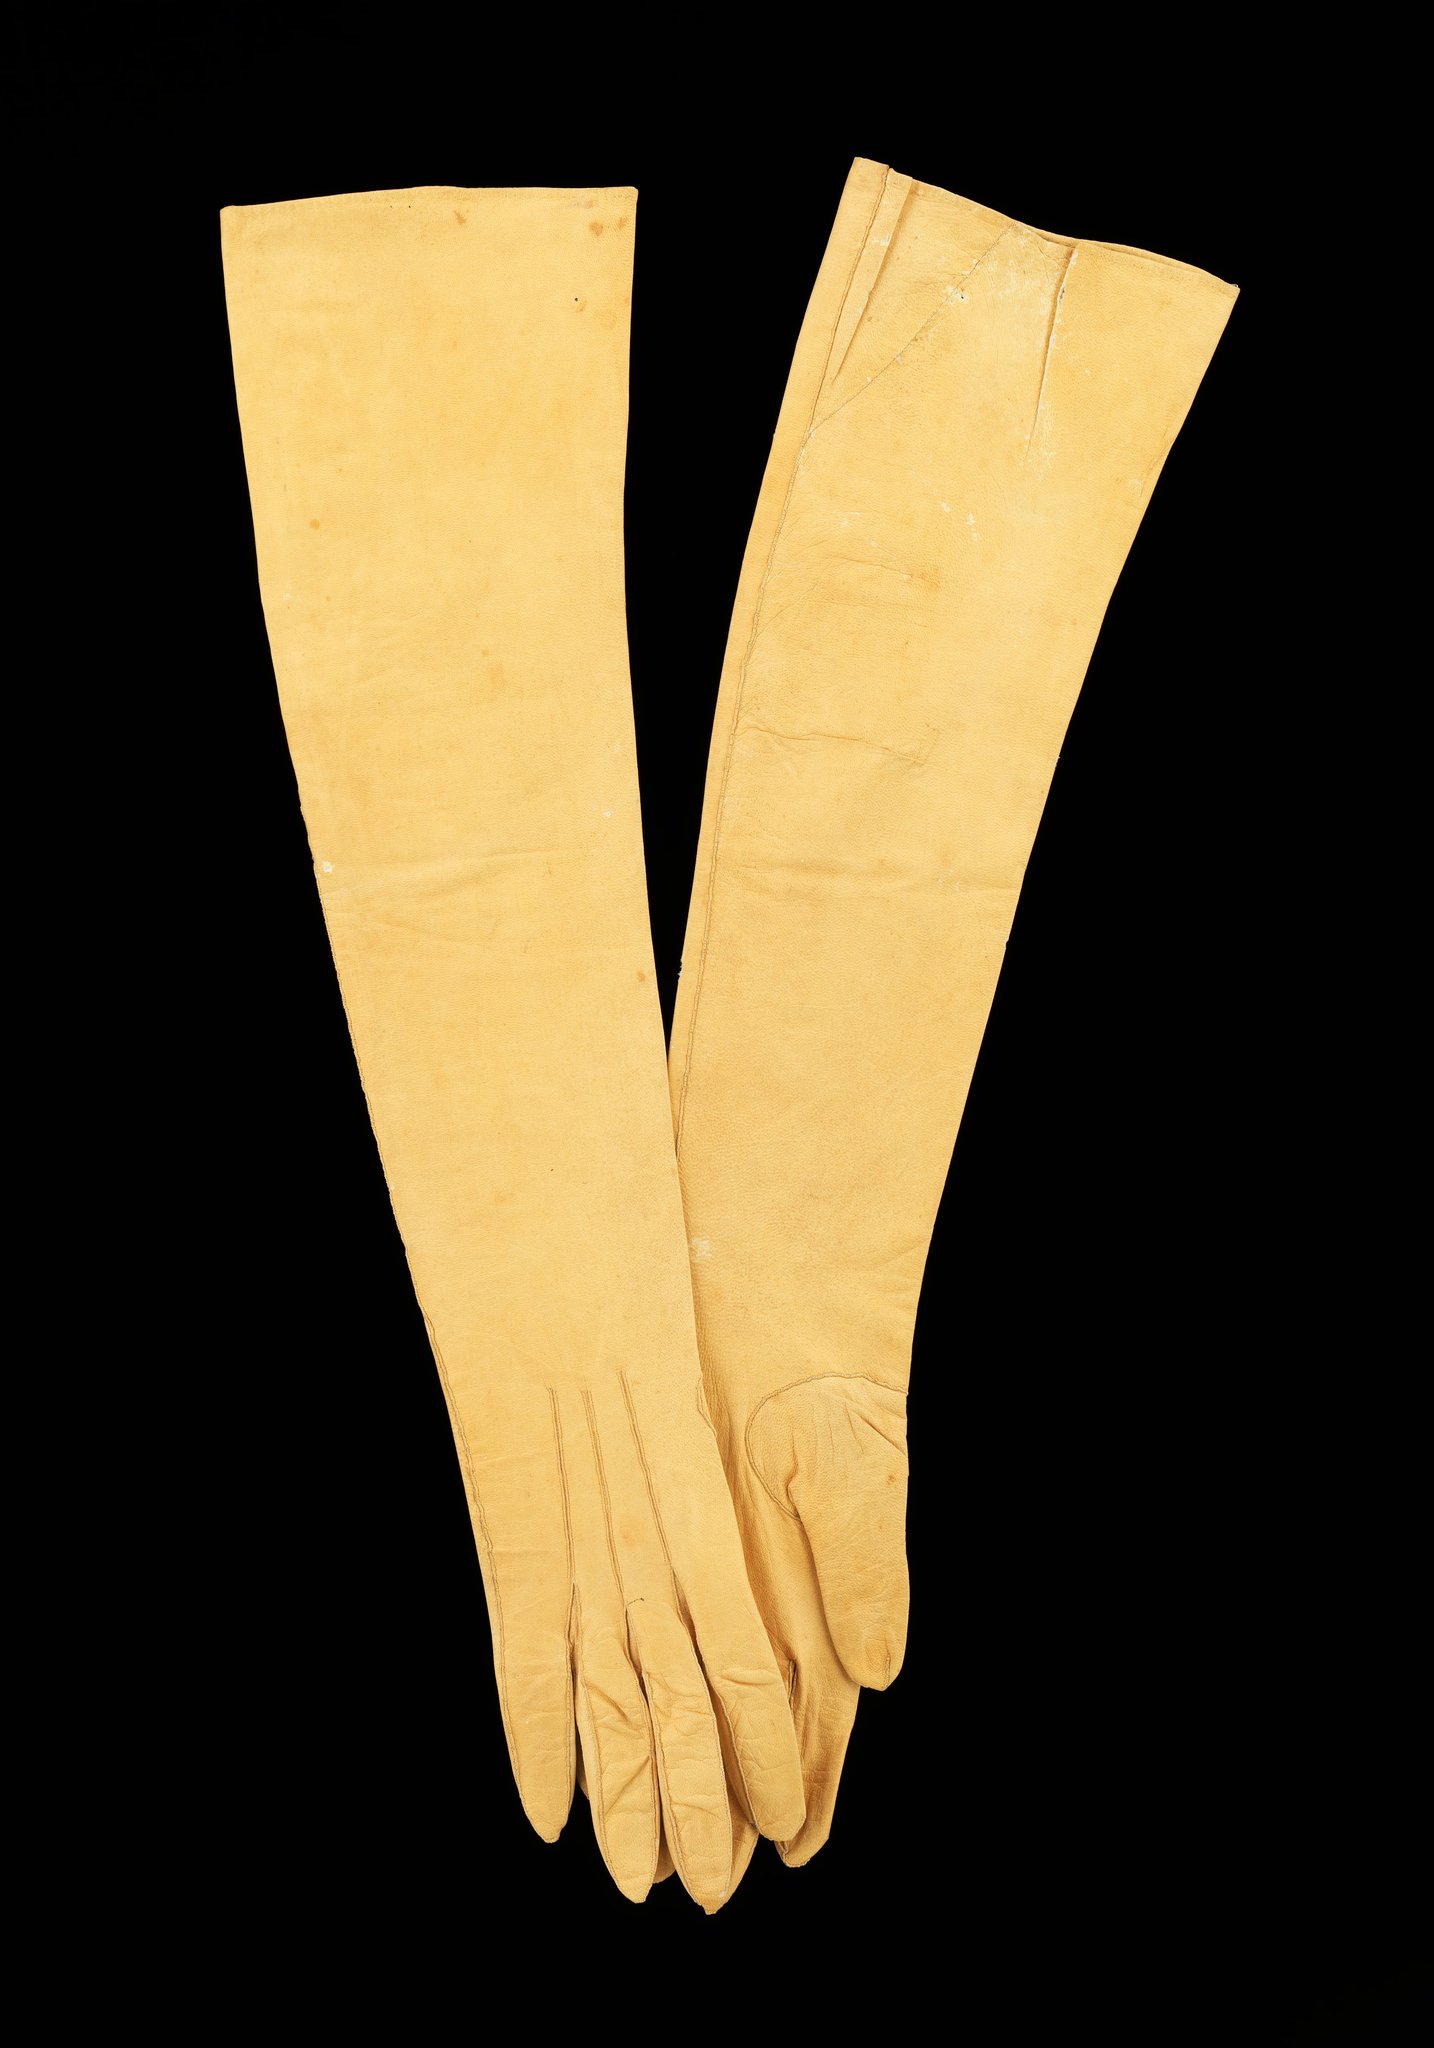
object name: evening glove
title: Evening gloves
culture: american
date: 1805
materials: leather